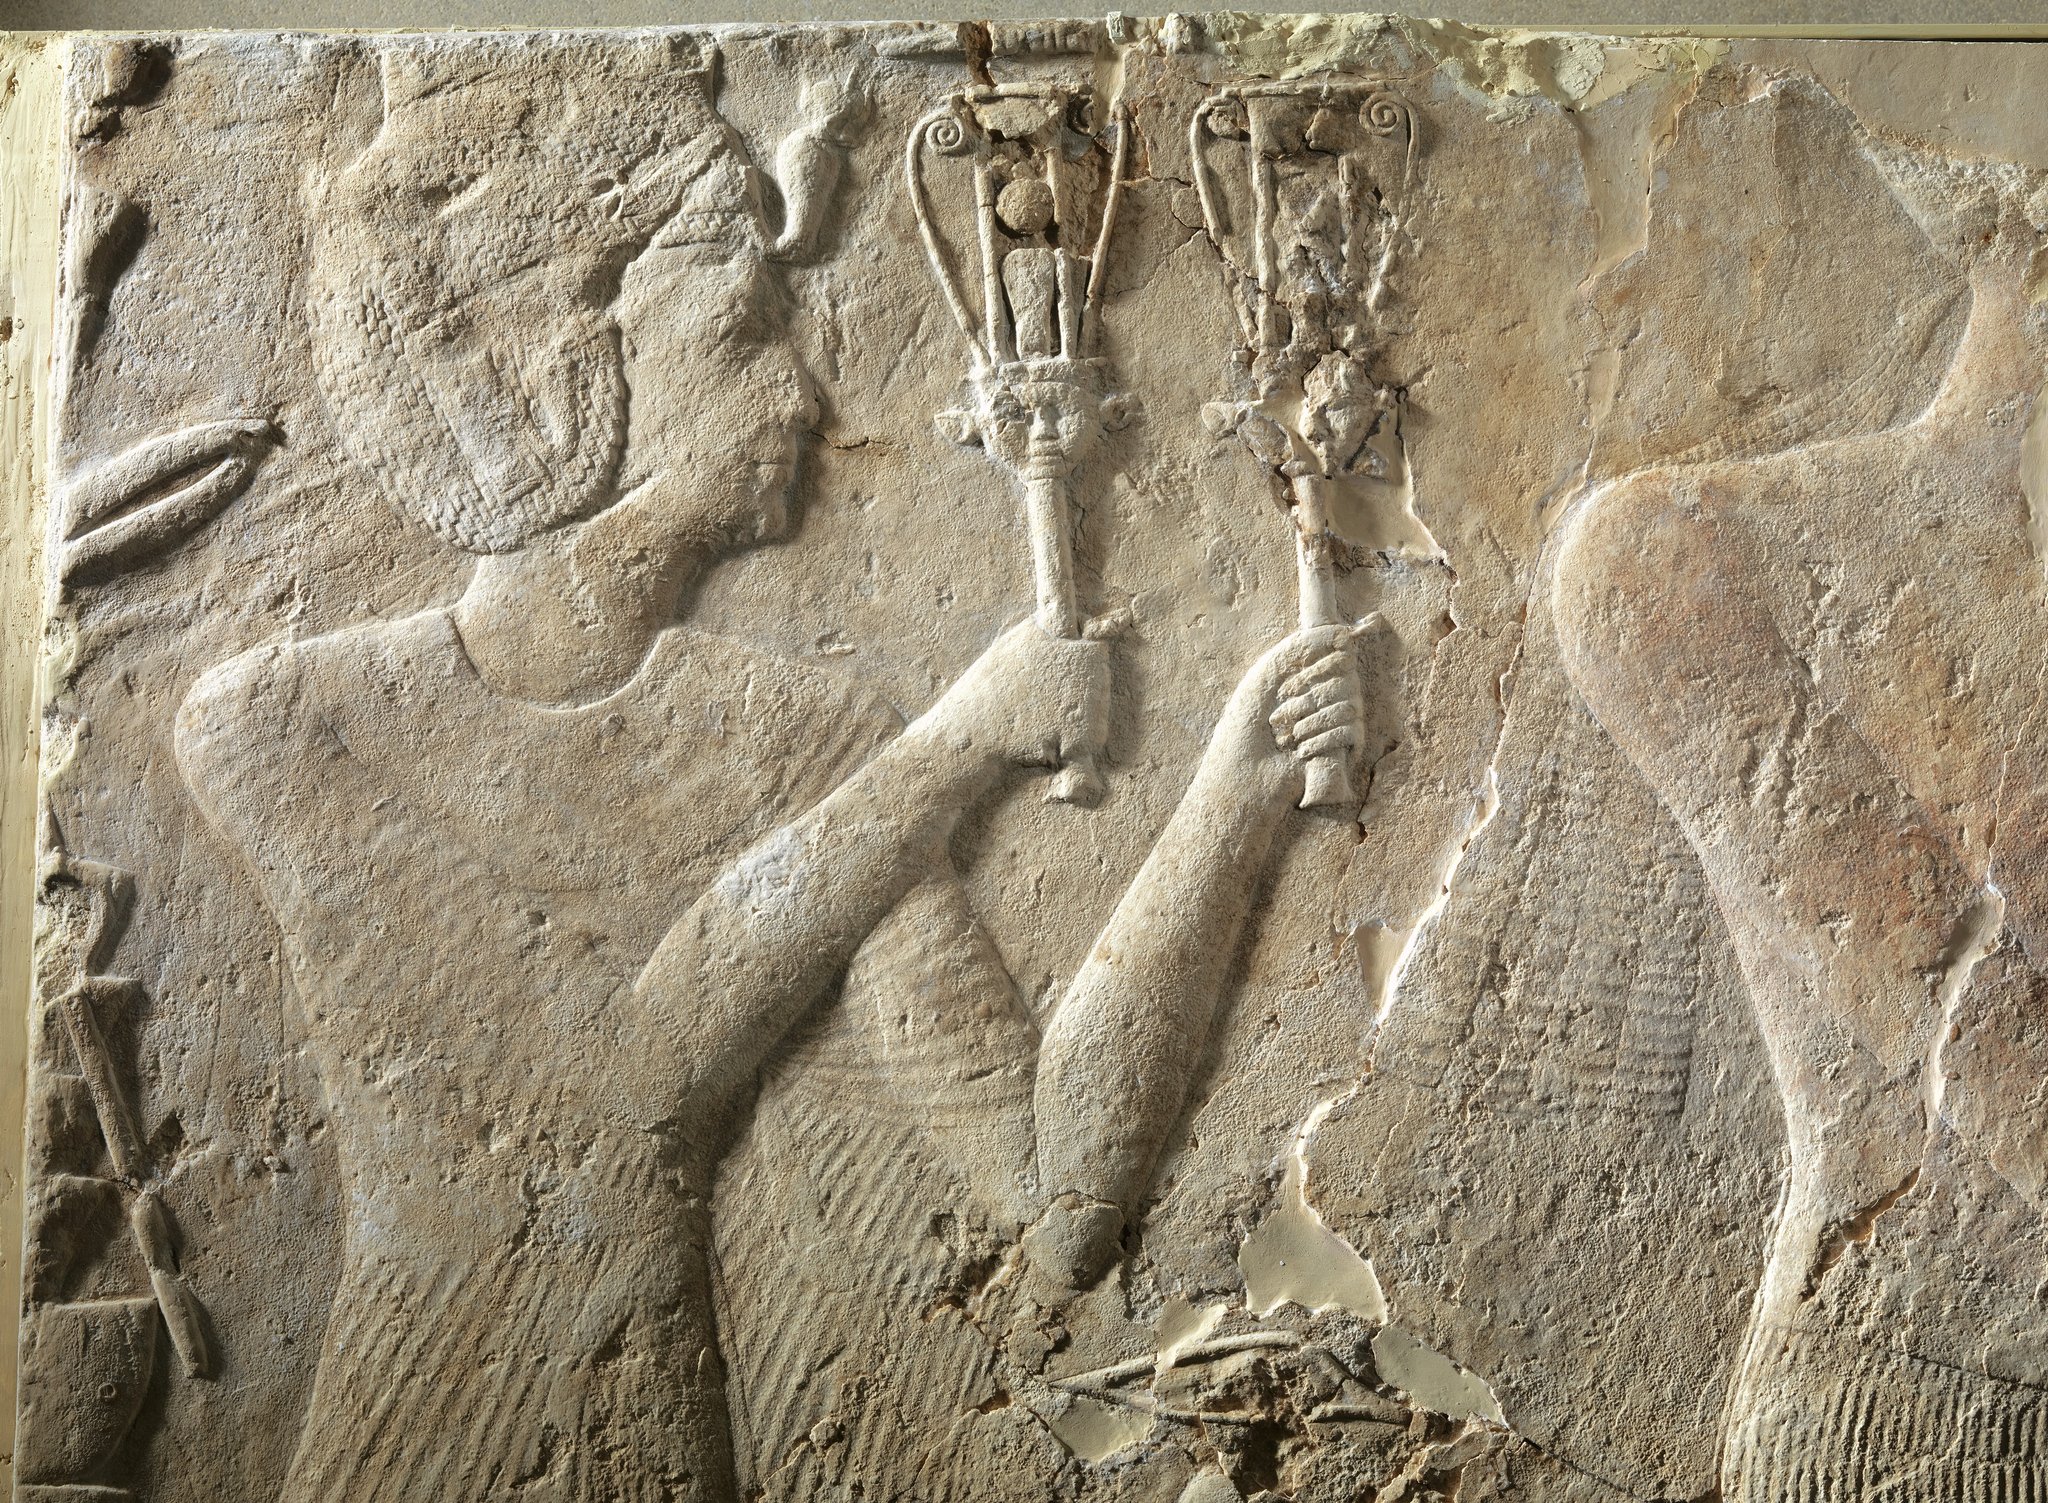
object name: relief, ramesses i chapel, south wall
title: Relief from the South Wall of a Chapel of Ramesses I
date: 1295-1294 BCE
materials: limestone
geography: egypt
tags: food,men,women,hieroglyphs